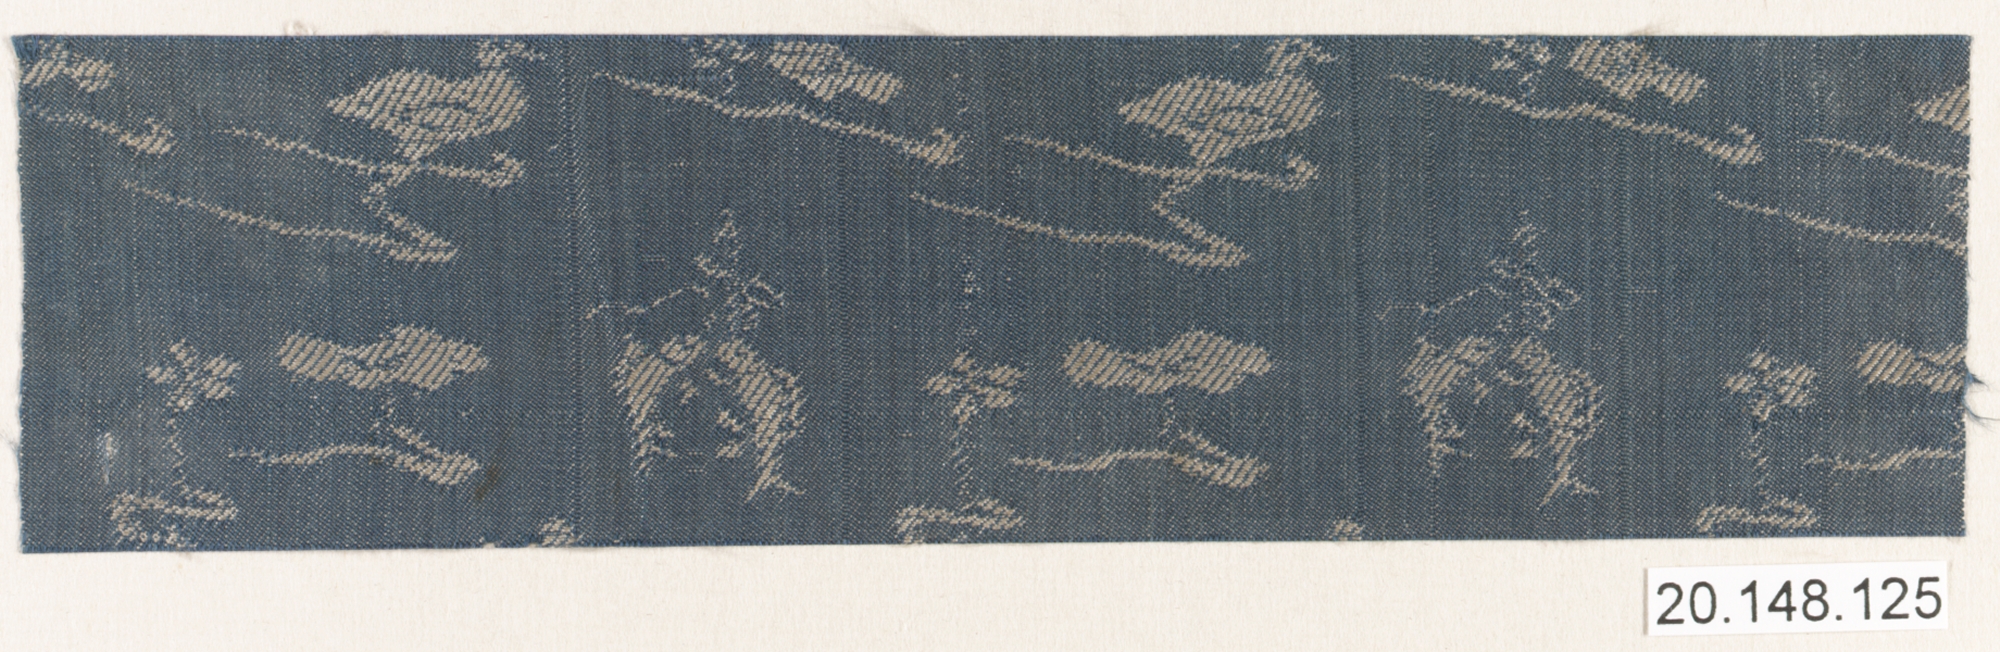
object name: piece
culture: japanese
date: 1601-1700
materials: silk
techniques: compound weave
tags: birds